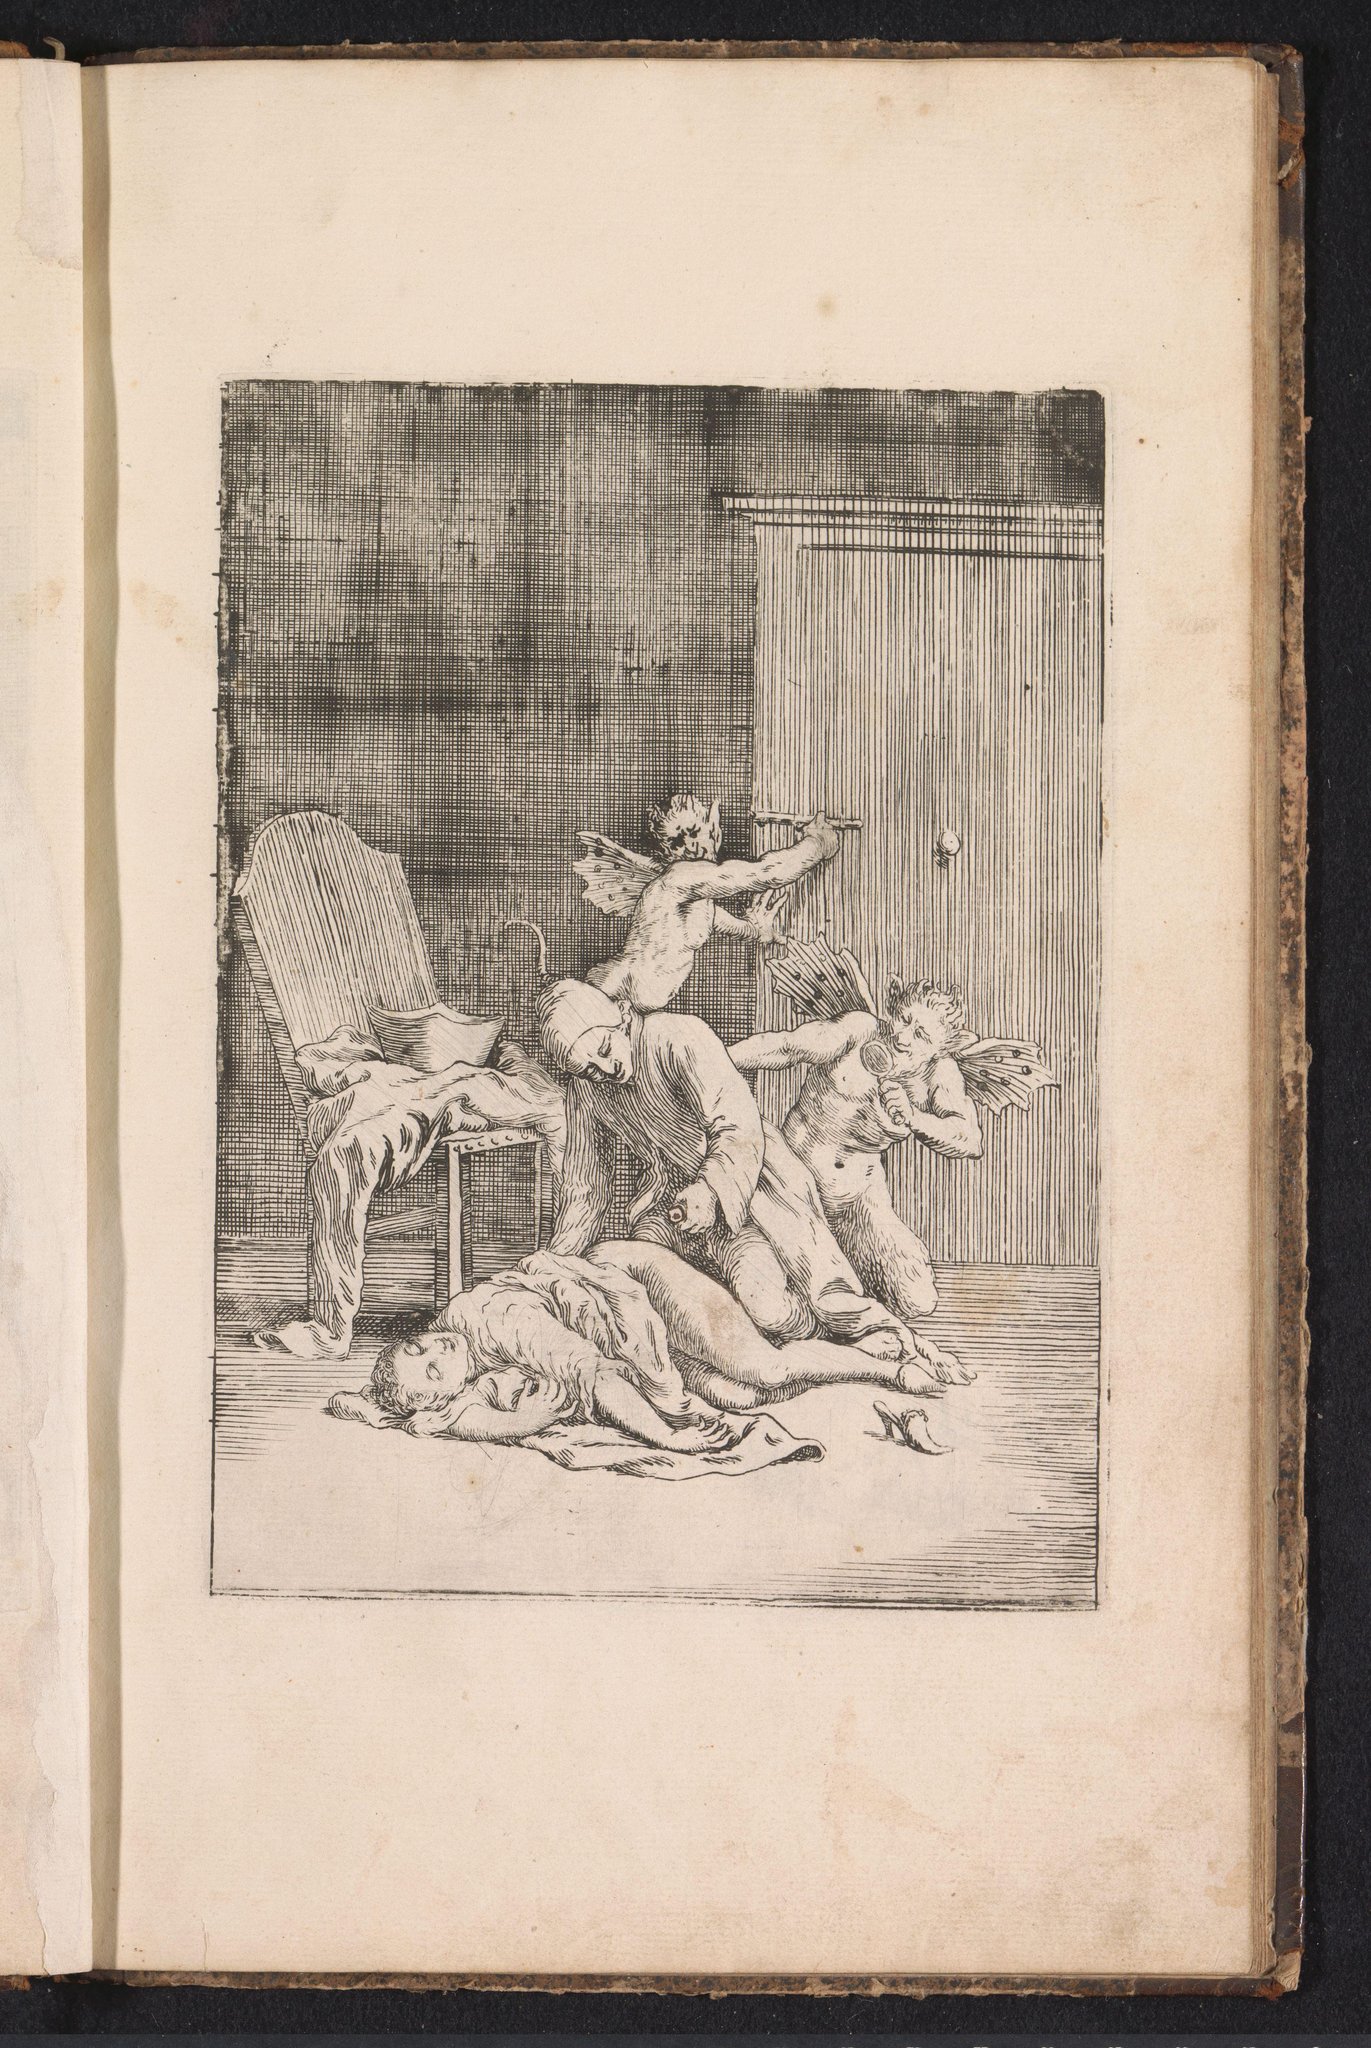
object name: print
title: Jean-Baptiste Girard vergrijpt zich aan Marie-Catherine Cadière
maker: jacques gabriel huquier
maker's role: draughtsman, painter, print maker, publisher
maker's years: 1725-1805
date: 1735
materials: paper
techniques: etching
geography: france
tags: toulon, witch, sorcerer with the devil and/or demons, sexual abuses of monks, coitus, cohabiting, sexual intercourse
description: Jean-Baptiste Girard vergrijpt zich aan de flauwgevallen Marie-Catherine Cadière. Onderdeel van de reeks van 32, veelal erotisch getinte, prenten gewijd aan het schandaal rond Marie-Catherine Cadière en de Jezuïet Jean-Baptiste Girard in 1730-1731.